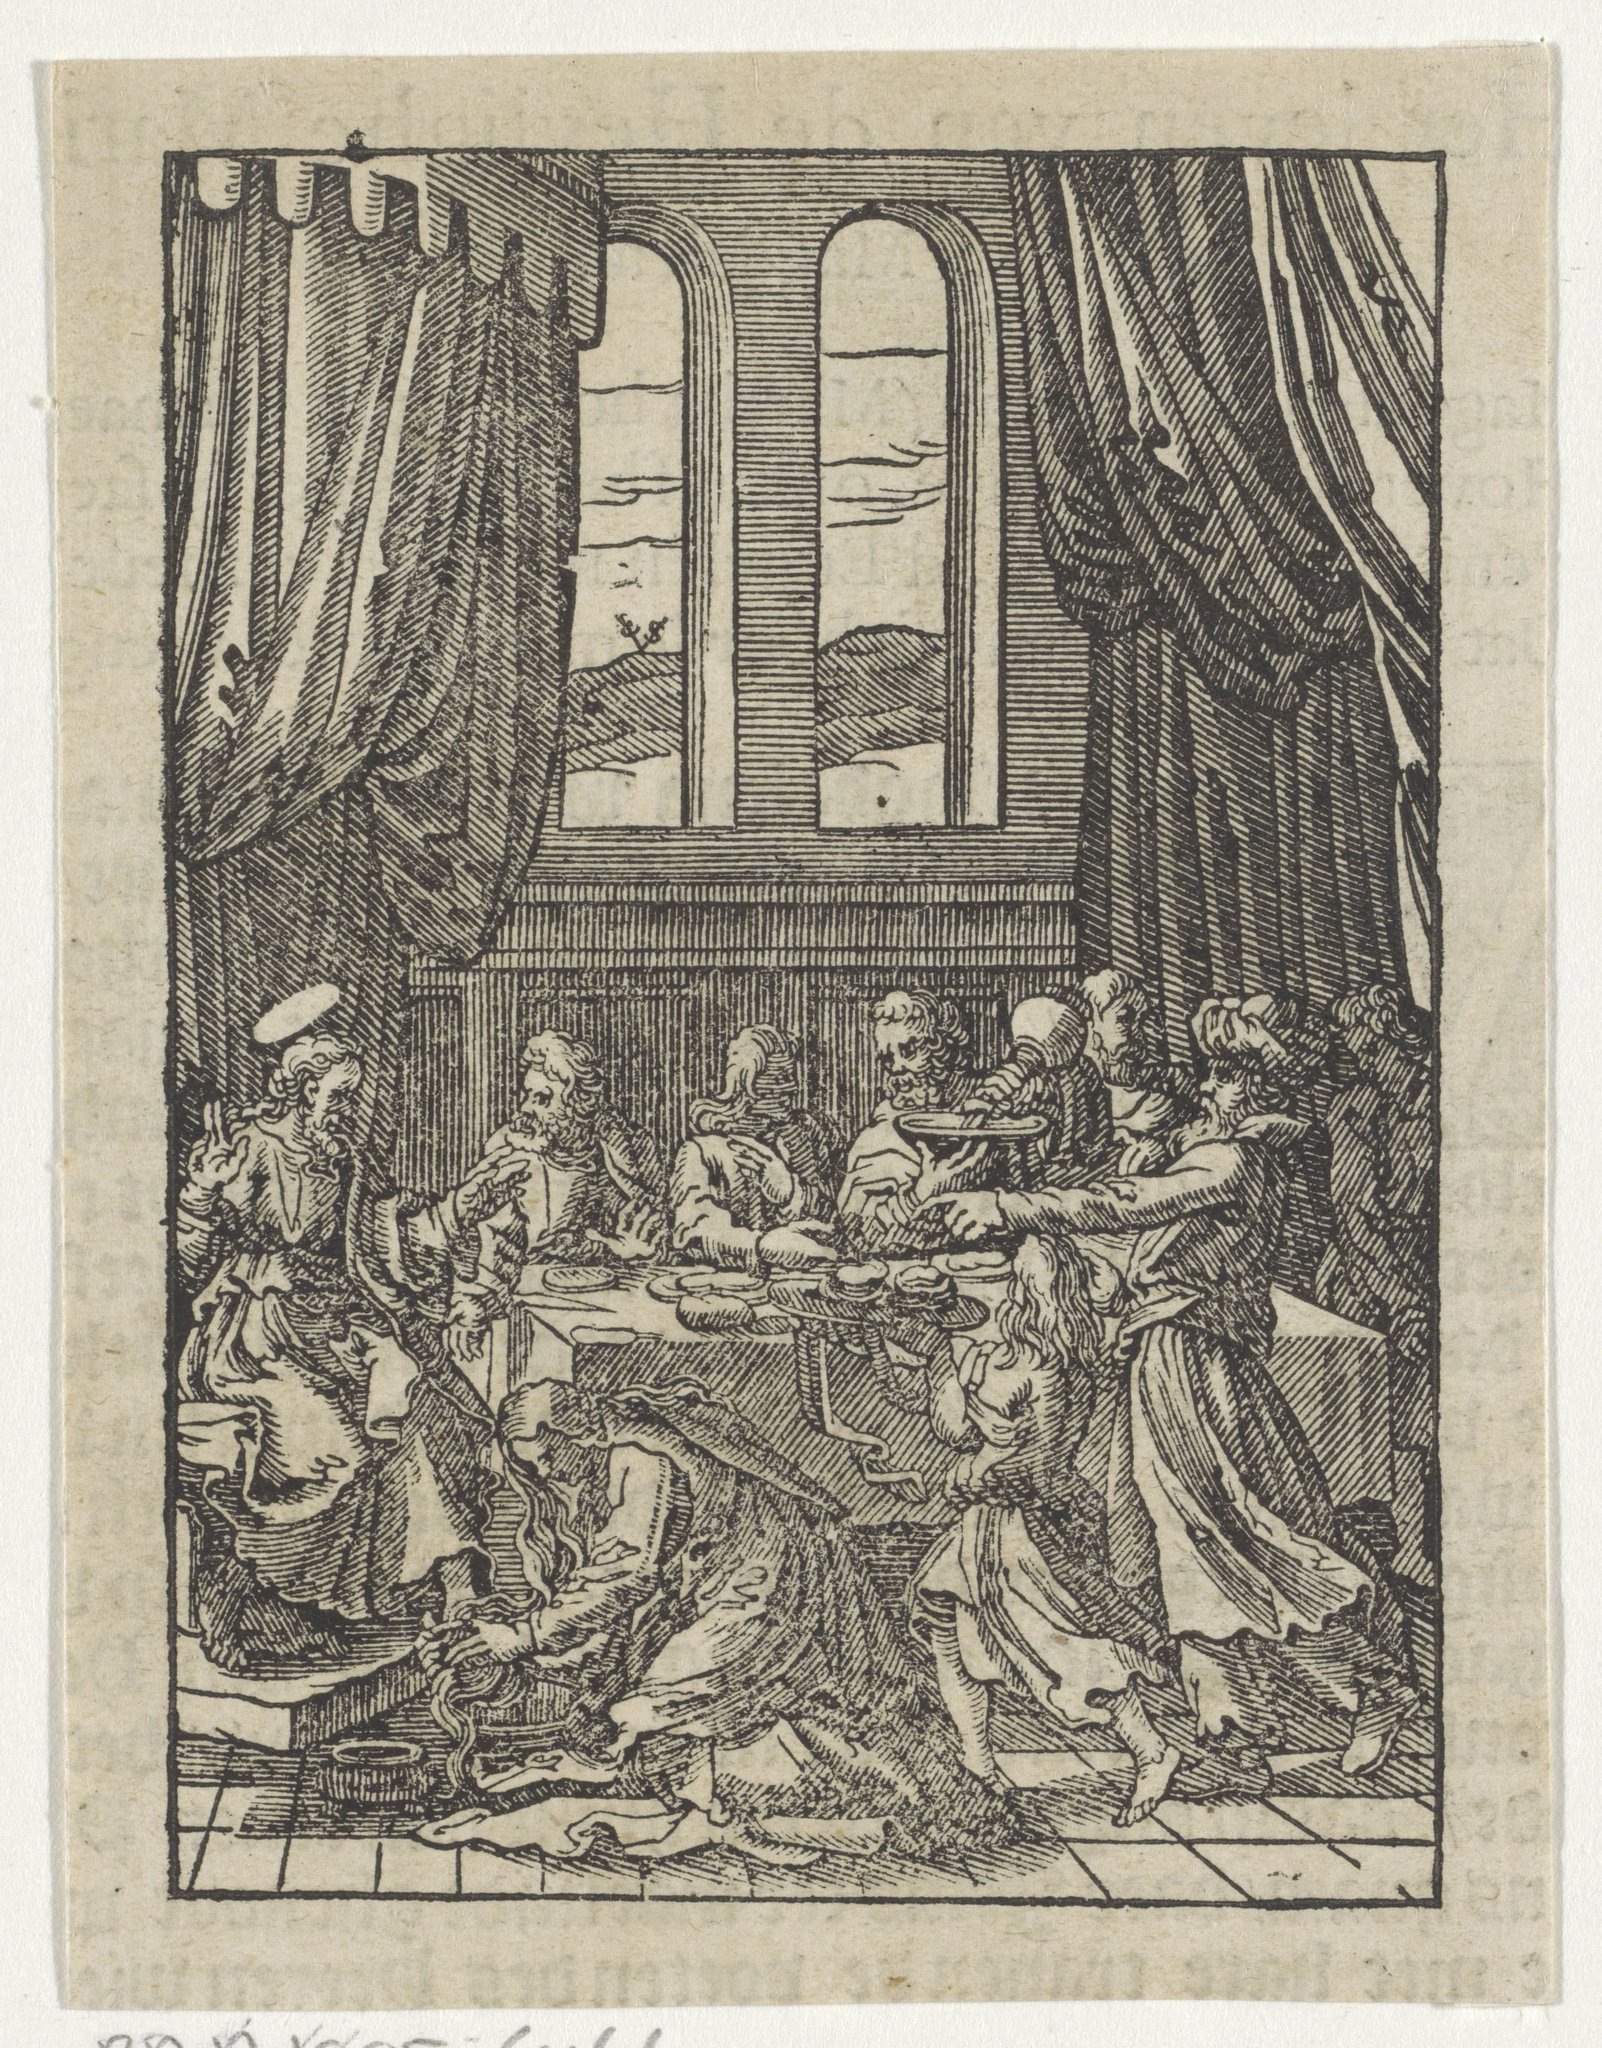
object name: print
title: Christus gezalfd door Maria Magdalena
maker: christoffel van sichem (ii)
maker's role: print maker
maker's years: 1581-1658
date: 1581-1658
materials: paper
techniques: letterpress printing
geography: amsterdam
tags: christ's feet are anointed by mary (magdalene)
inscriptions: collector's mark: Lugt 2228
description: Christus zit aan tafel te eten in het huis van Simon de Farizeeër. Maria Magdalena knielt op de grond zalft zijn voeten en droogt ze met haar haren.